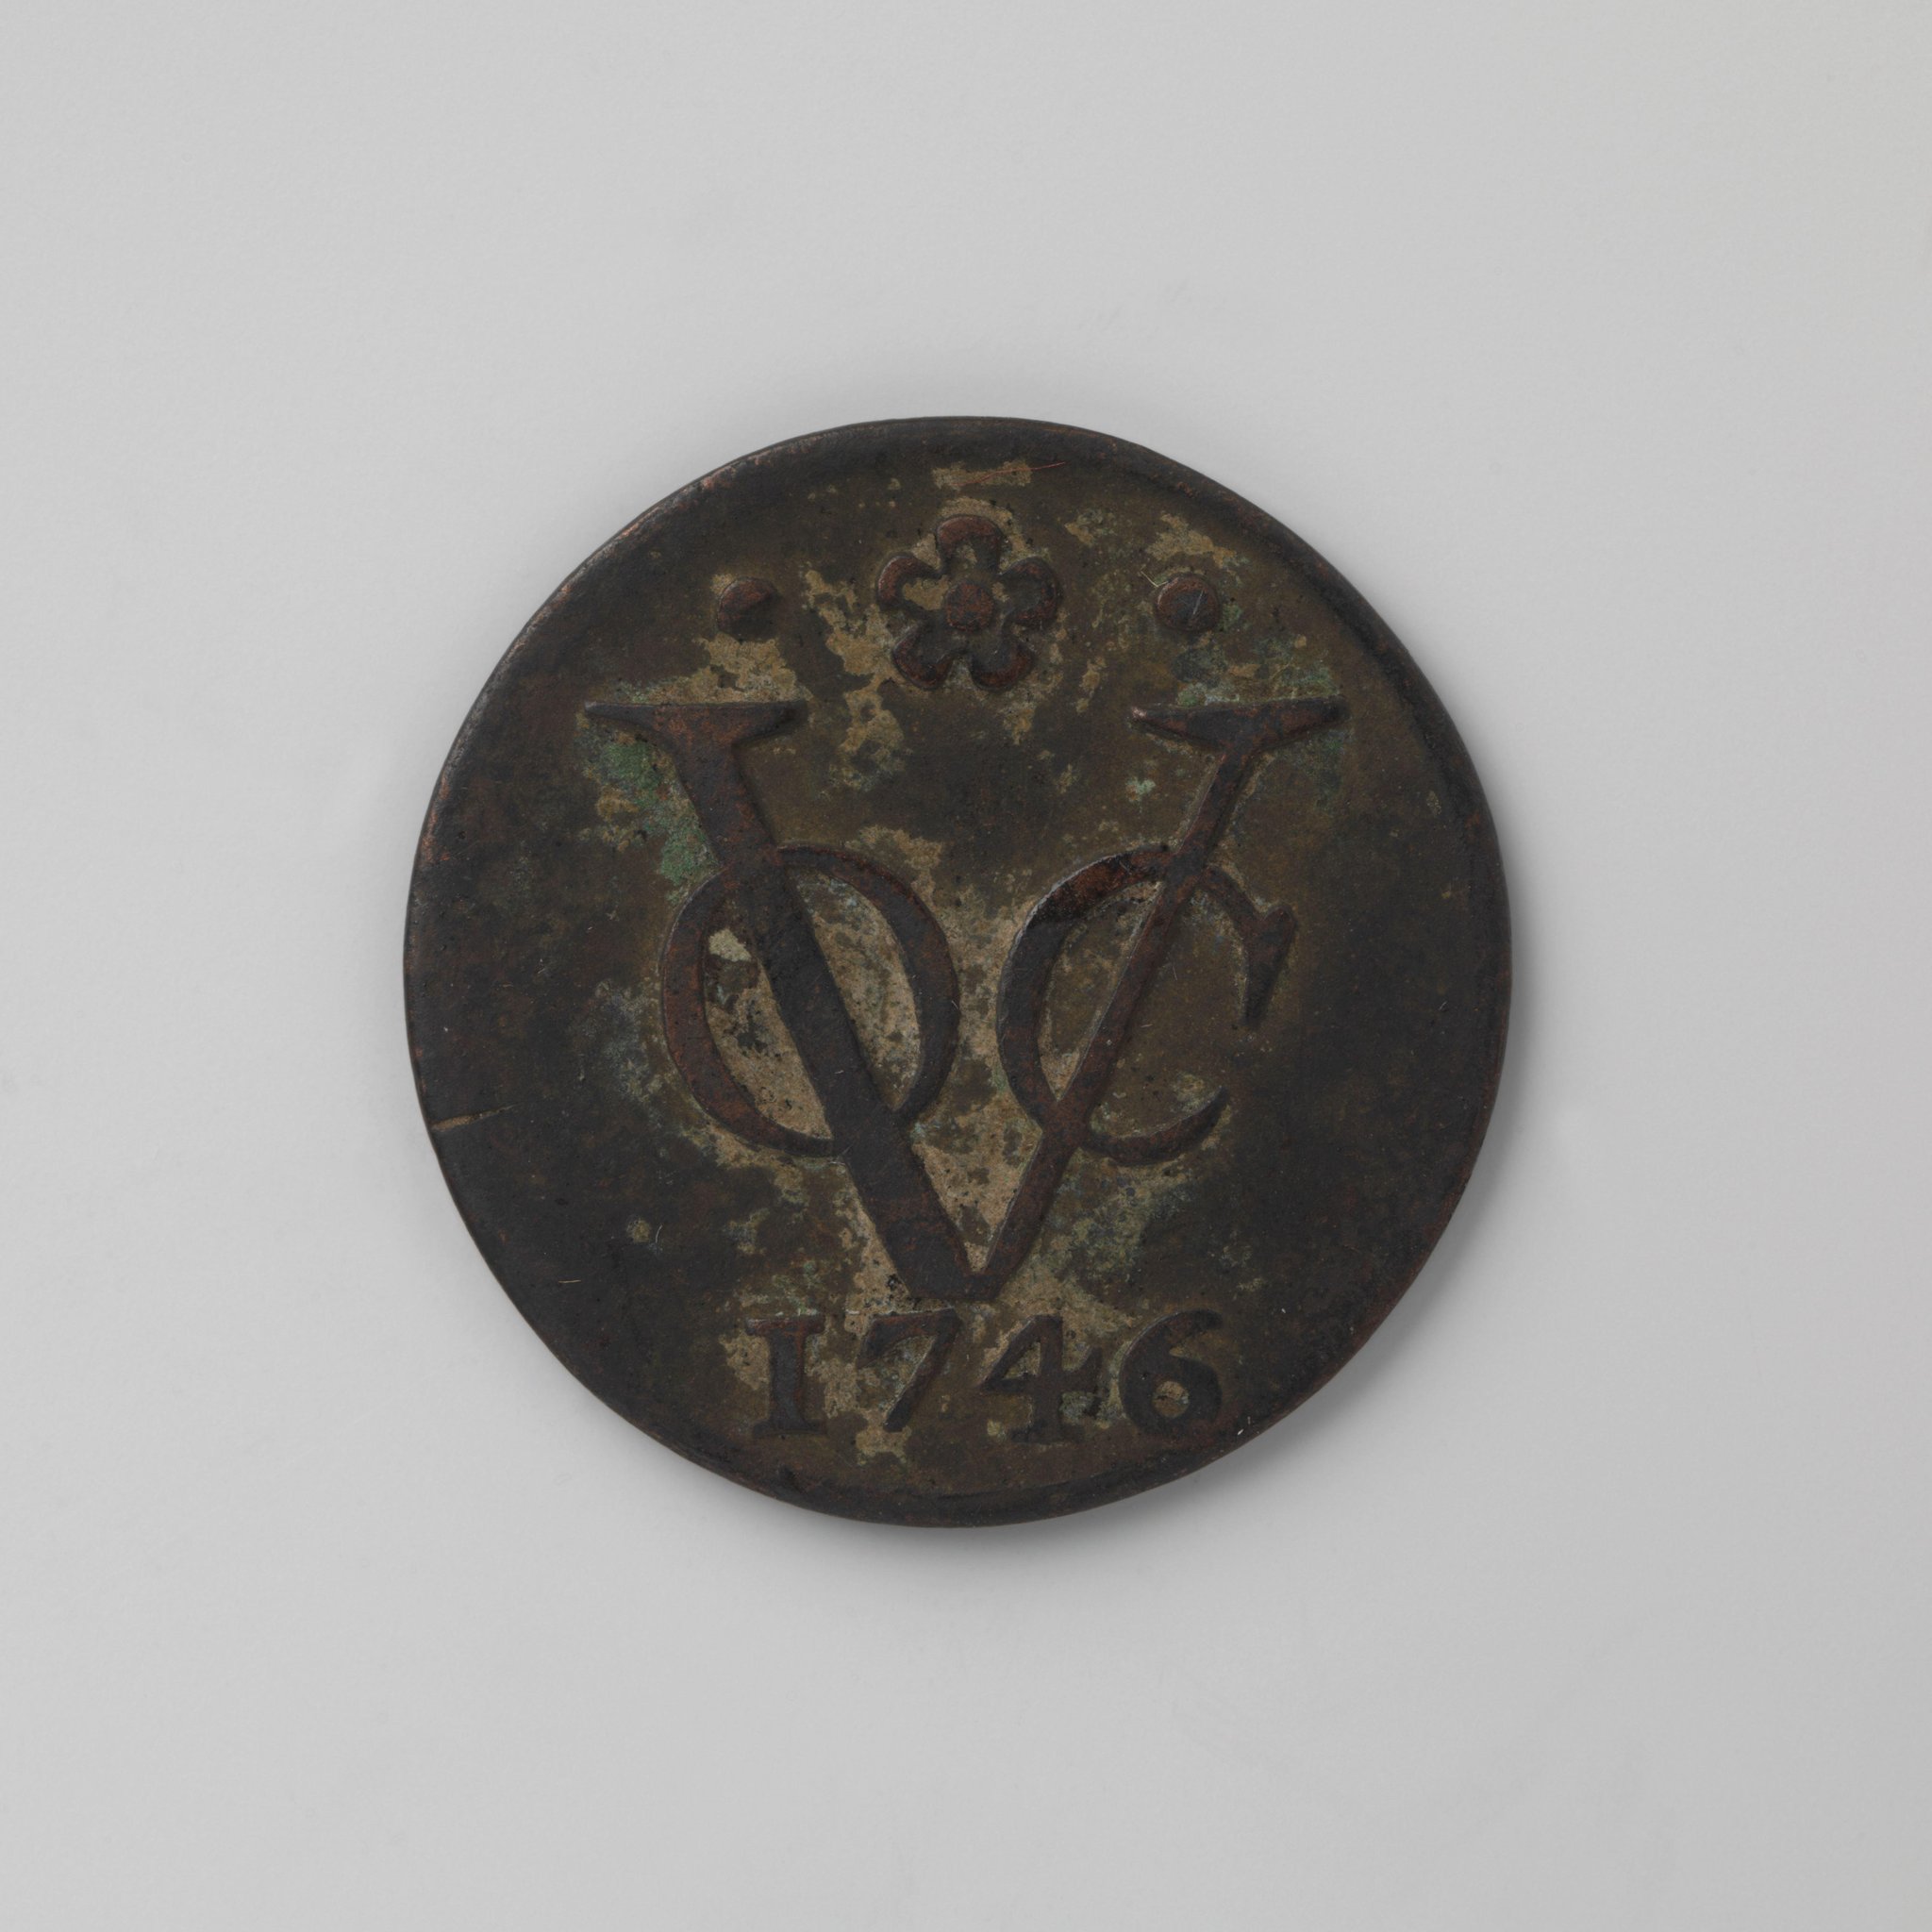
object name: coin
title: Duit van de VOC uit Holland, 1746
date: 1746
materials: copper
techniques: striking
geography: dordrecht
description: Koperen munt. Voorzijde: gekroond wapenschild van Holland. Keerzijde: monogram van de VOC, waarboven muntteken en waaronder jaartal. Gladde rand.